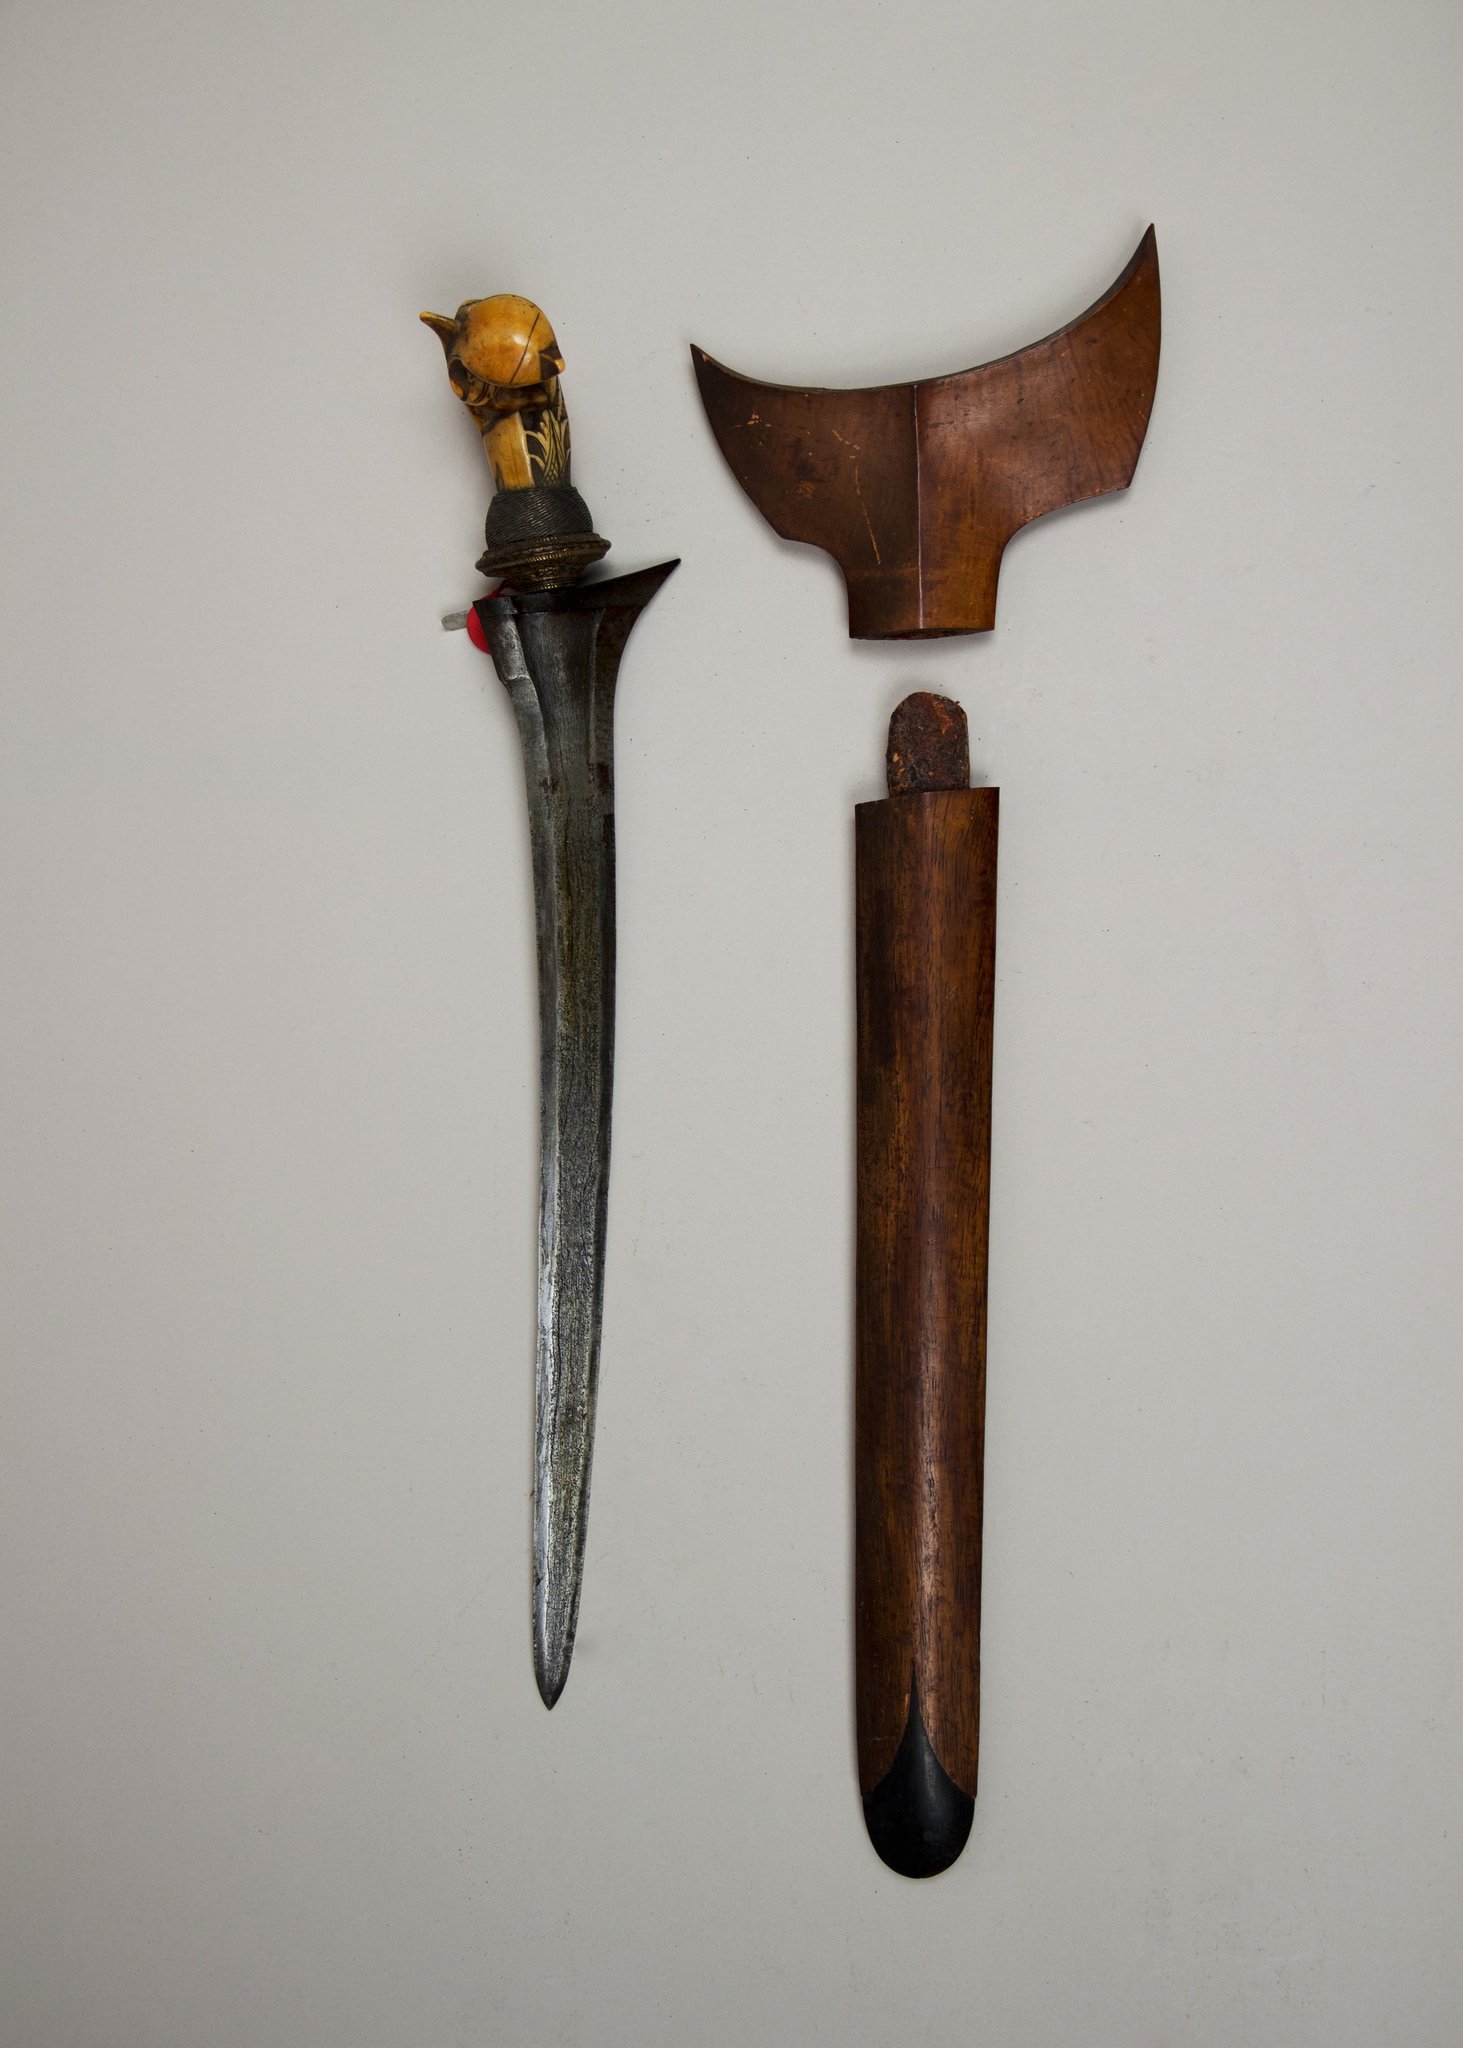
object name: kris with sheath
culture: indonesian, sumbawa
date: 1701-1900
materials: bone, horn, silver, wood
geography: indonesia